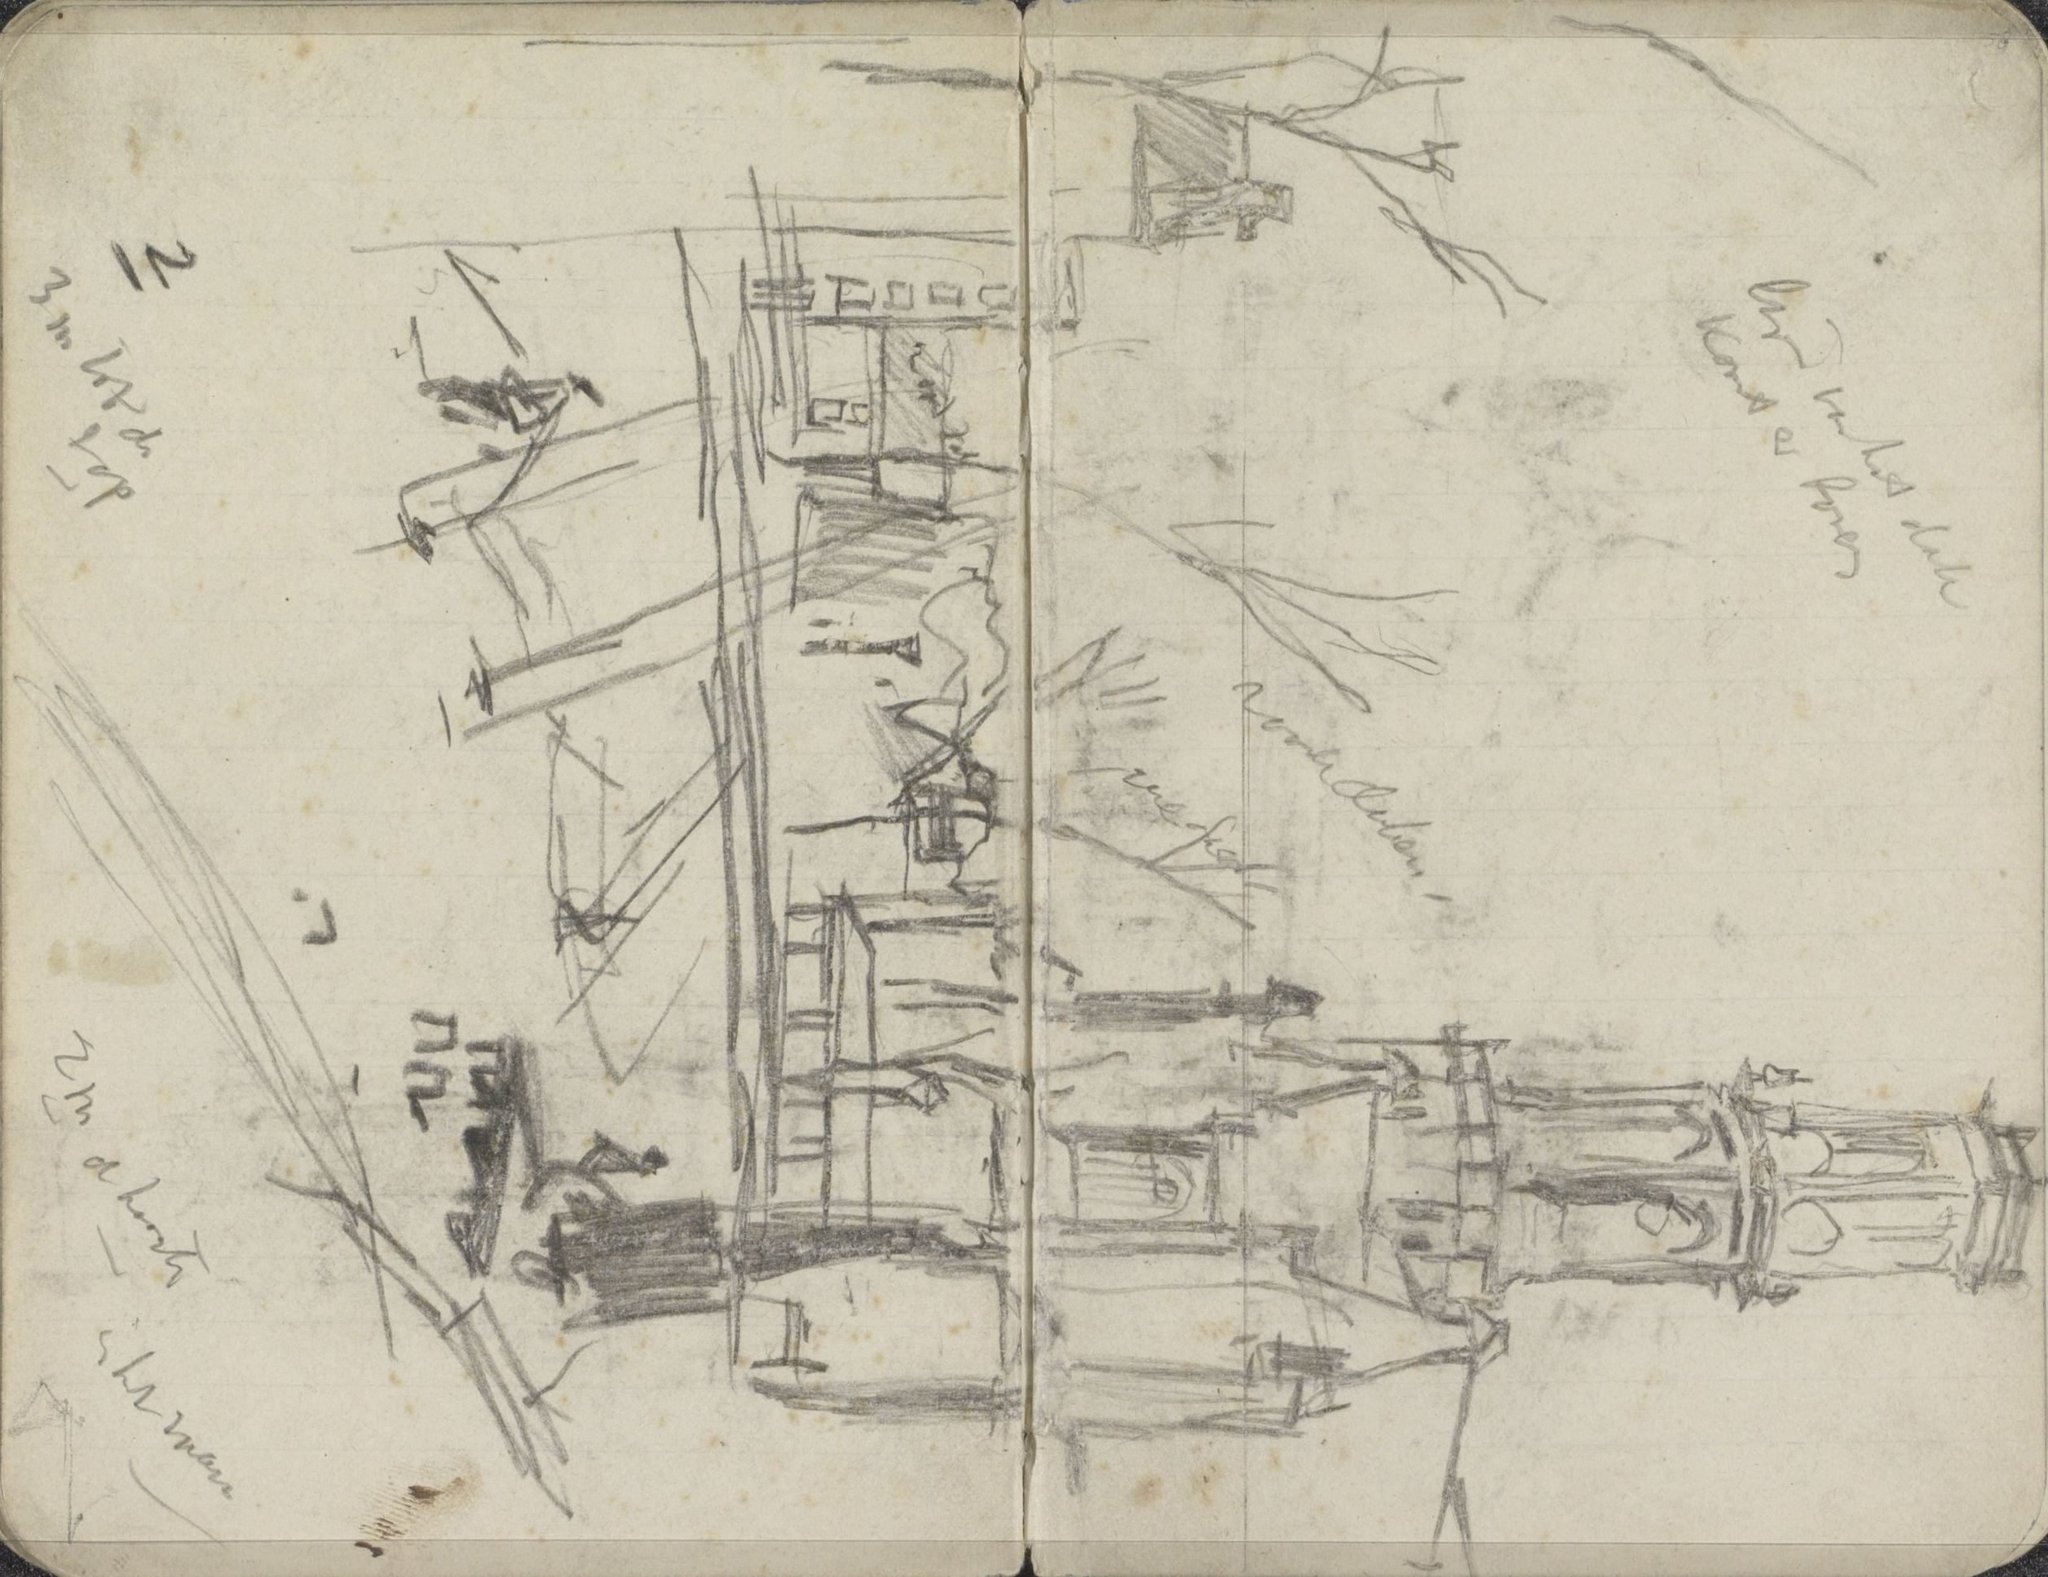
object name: sketchbook leaf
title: Gezicht op de Westerkerk in Amsterdam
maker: george hendrik breitner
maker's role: draughtsman, painter, print maker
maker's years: 1857-1923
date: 1898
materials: chalk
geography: amsterdam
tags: building-site (+ labourers ~ crafts, industries, agriculture), church (exterior), square, place, circus, etc. (+ city(-scape) with figures, staffage)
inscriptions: annotation: ‘[...] van het dak/ komt er boven/ [...]’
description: Bouwput van de winkelgalerij in de Raadhuisstraat met rechts de Westerkerk. Vooraan heiende bouwvakkers. Pagina 57 en pagina 58 uit een schetsboek met 42 bladen.